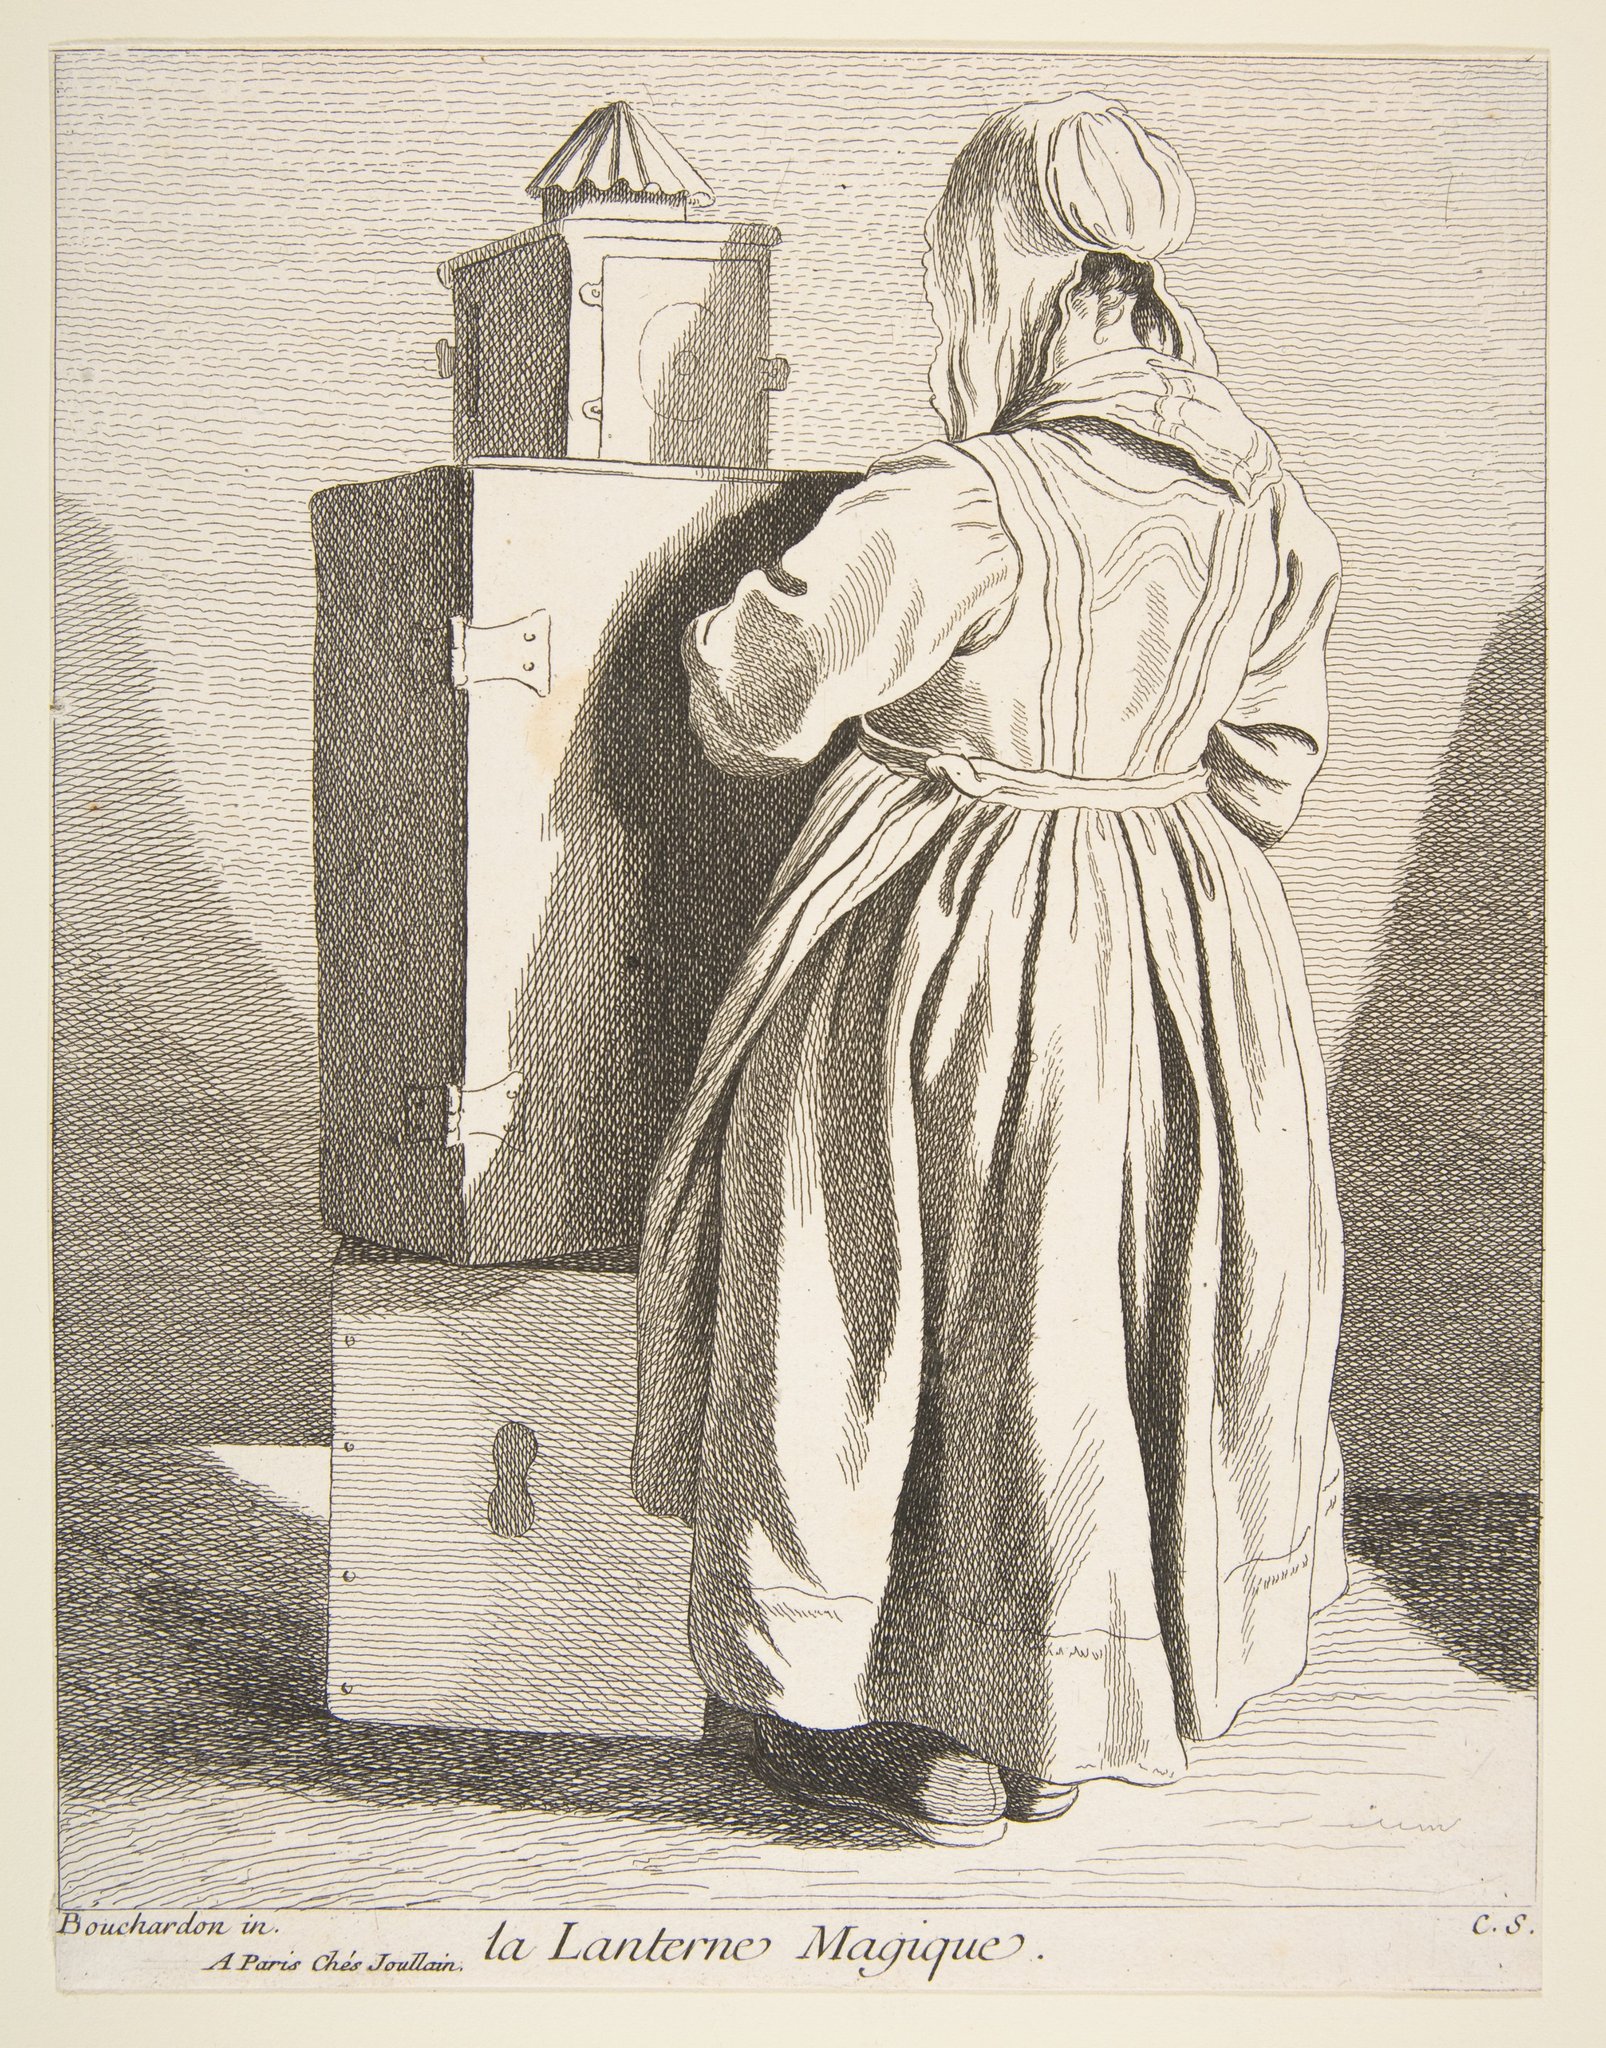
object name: print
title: The Magic Lantern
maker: anne claude philippe de tubières, comte de caylus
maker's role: artist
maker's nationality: french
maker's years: 1692-1765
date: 1737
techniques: engraving, etching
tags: women,lanterns